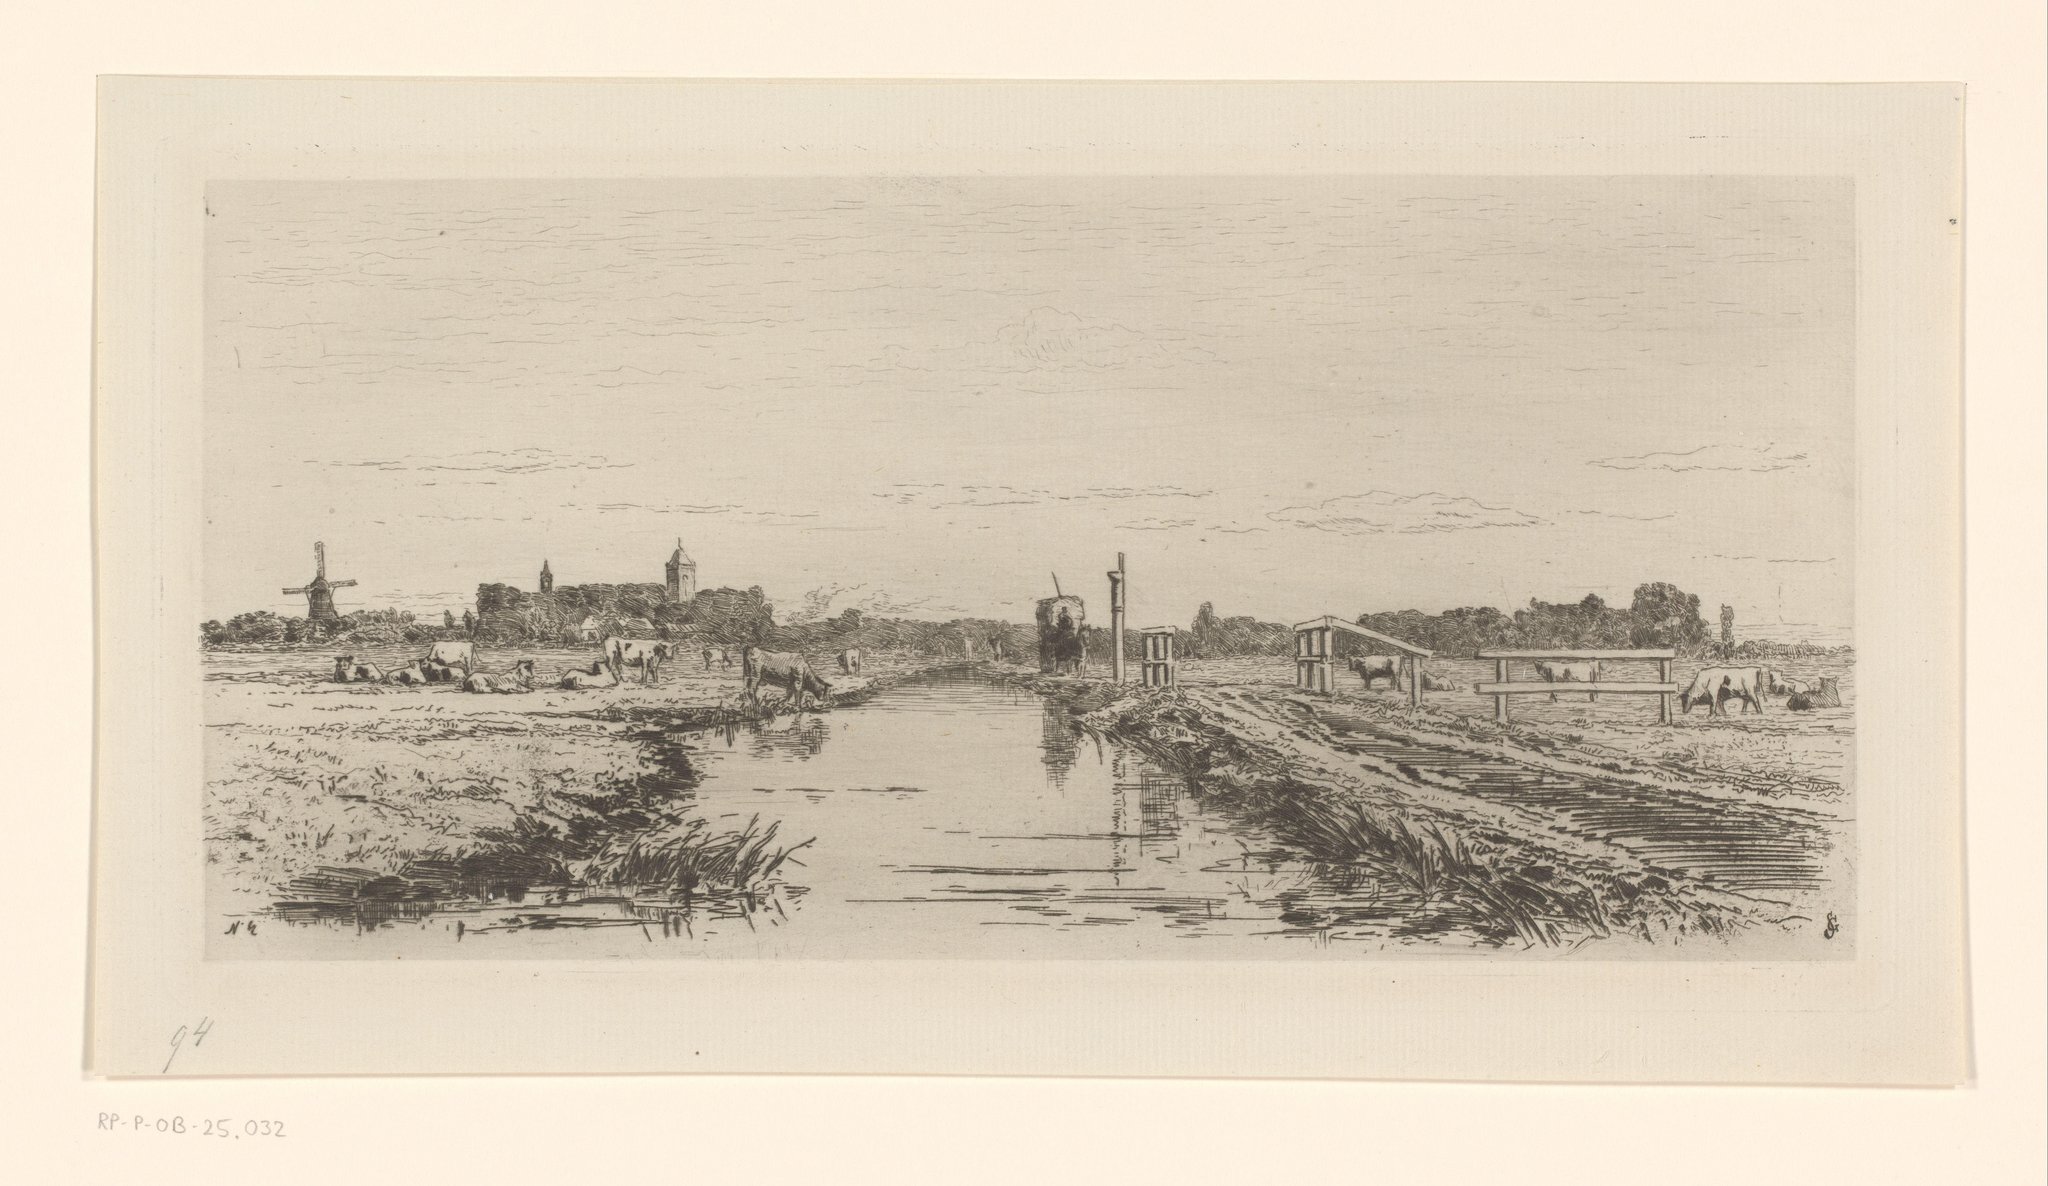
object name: print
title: La Hollande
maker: carel nicolaas storm van s-gravesande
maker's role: draughtsman, print maker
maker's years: 1841-1924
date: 1877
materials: paper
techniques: etching, intaglio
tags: river, road, path, bovine cattle, vecht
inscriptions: collector's mark: Lugt 2228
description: Landschap met in het midden een weg naast een rivier, mogelijk de Vecht. Op de weg rijdt een paard-en-wagen. Op de oever grazende koeien. Aan de horizon zijn een kerktoren en een molen te zien.